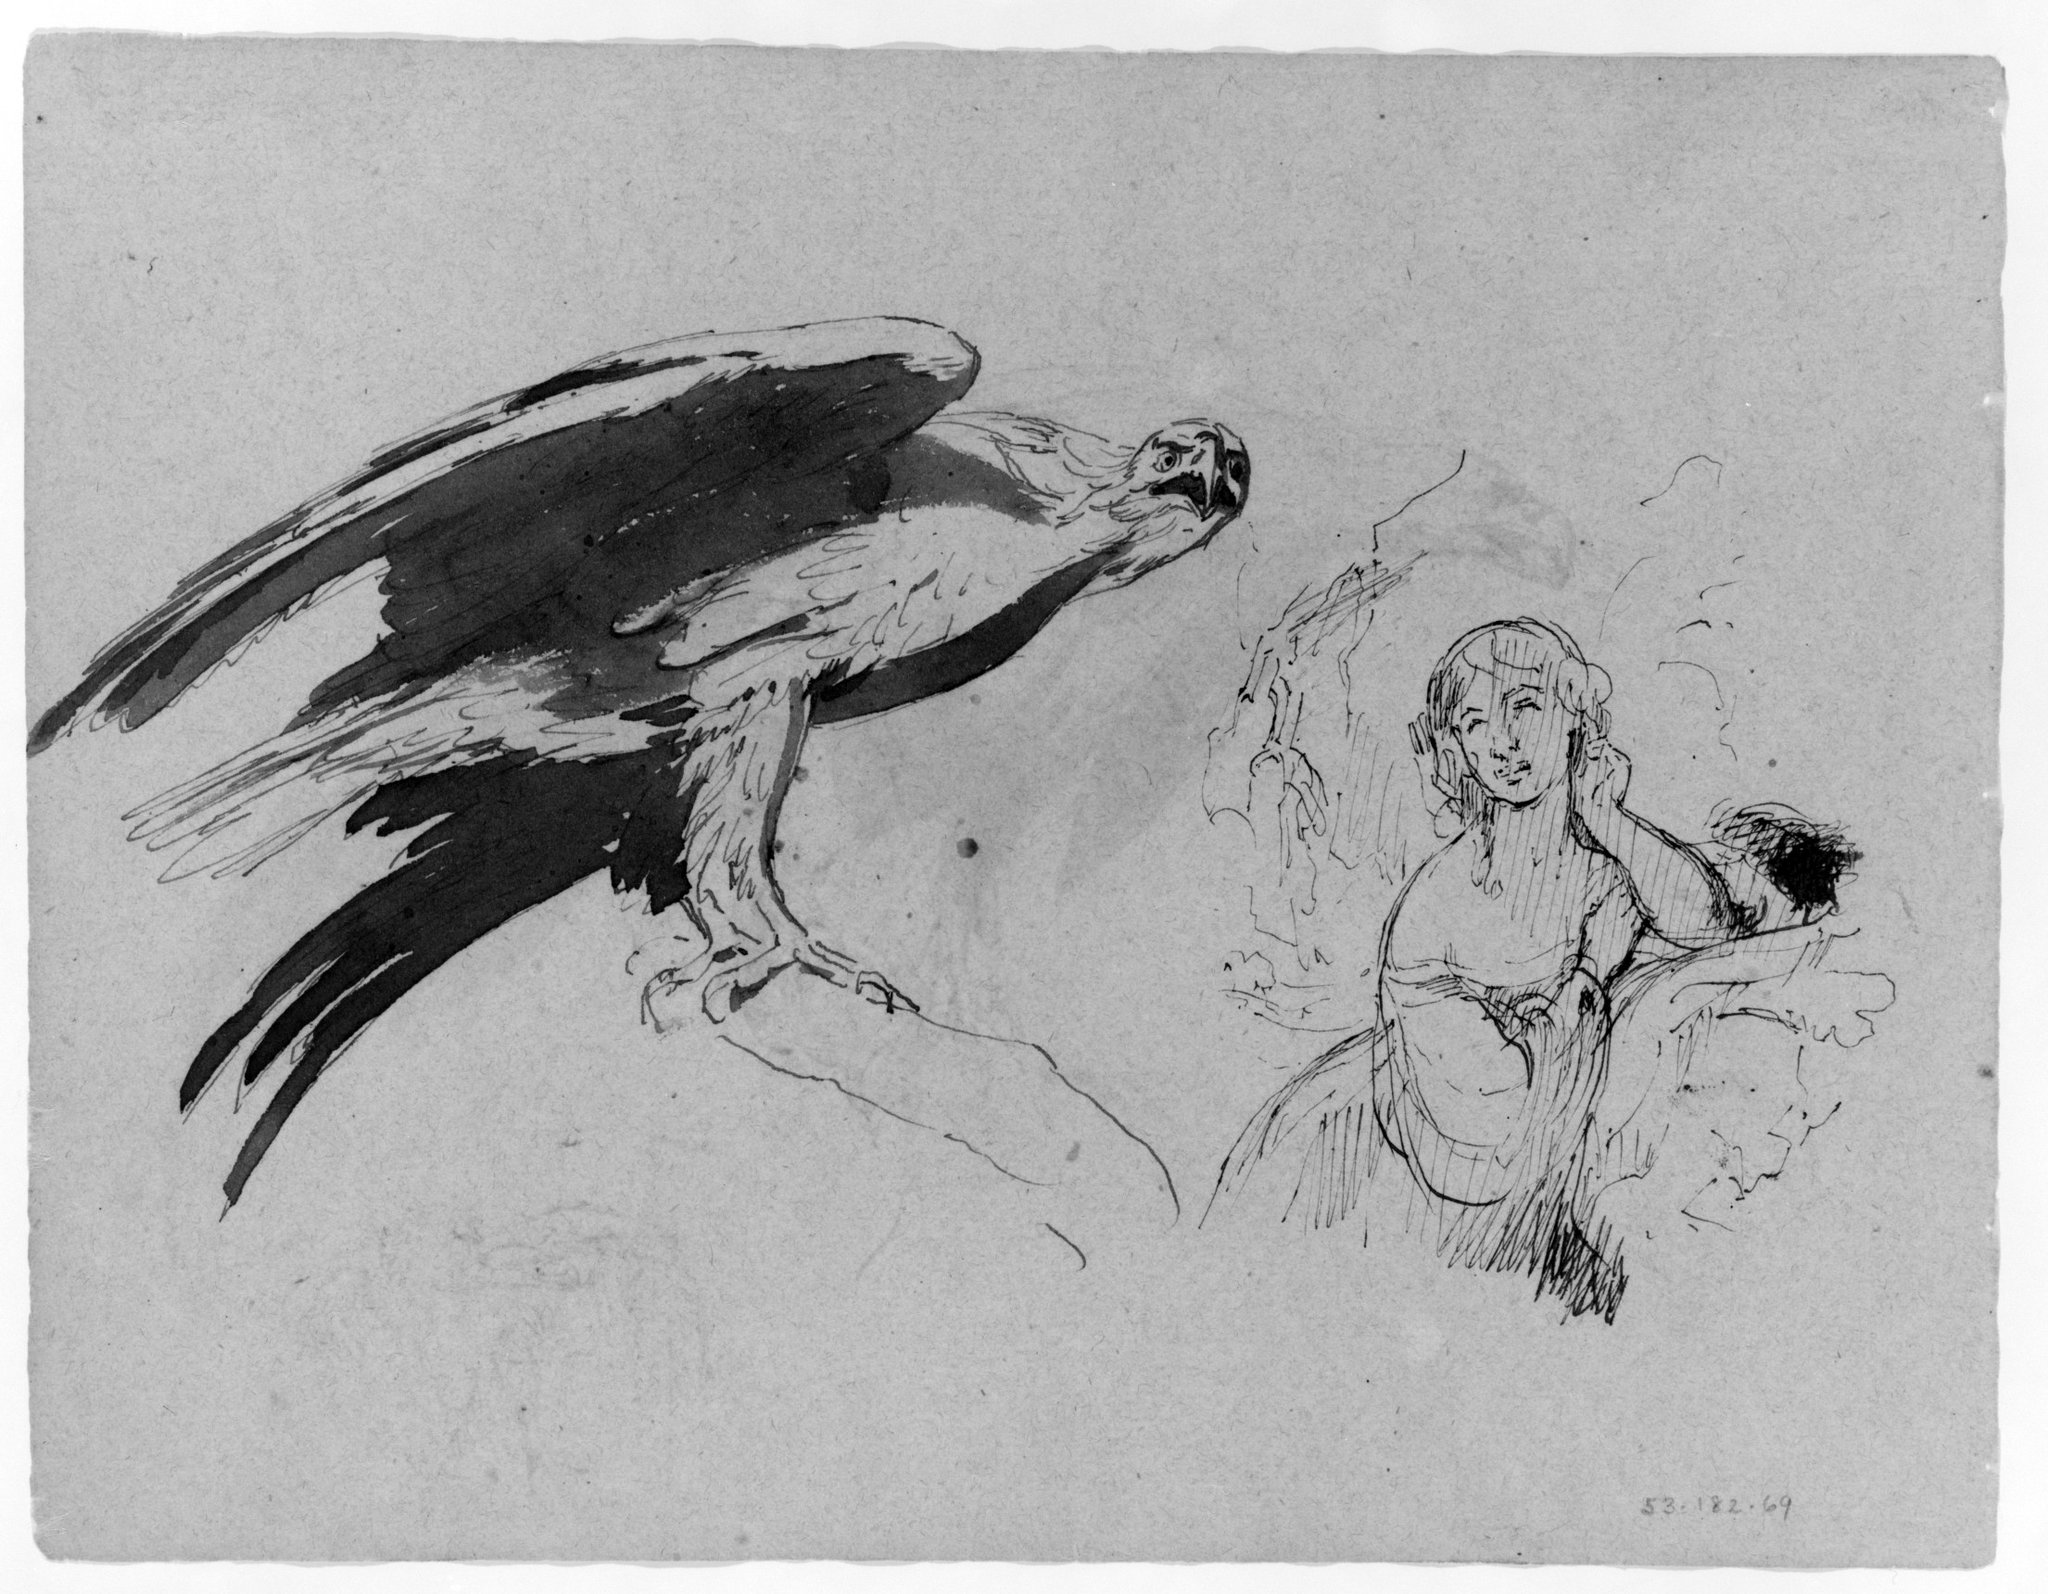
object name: drawing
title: Eagle and Lady (from Sketchbook)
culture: american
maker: thomas sully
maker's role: artist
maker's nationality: american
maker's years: 1783-1872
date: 1810-1820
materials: ink, paper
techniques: wash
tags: eagles,women